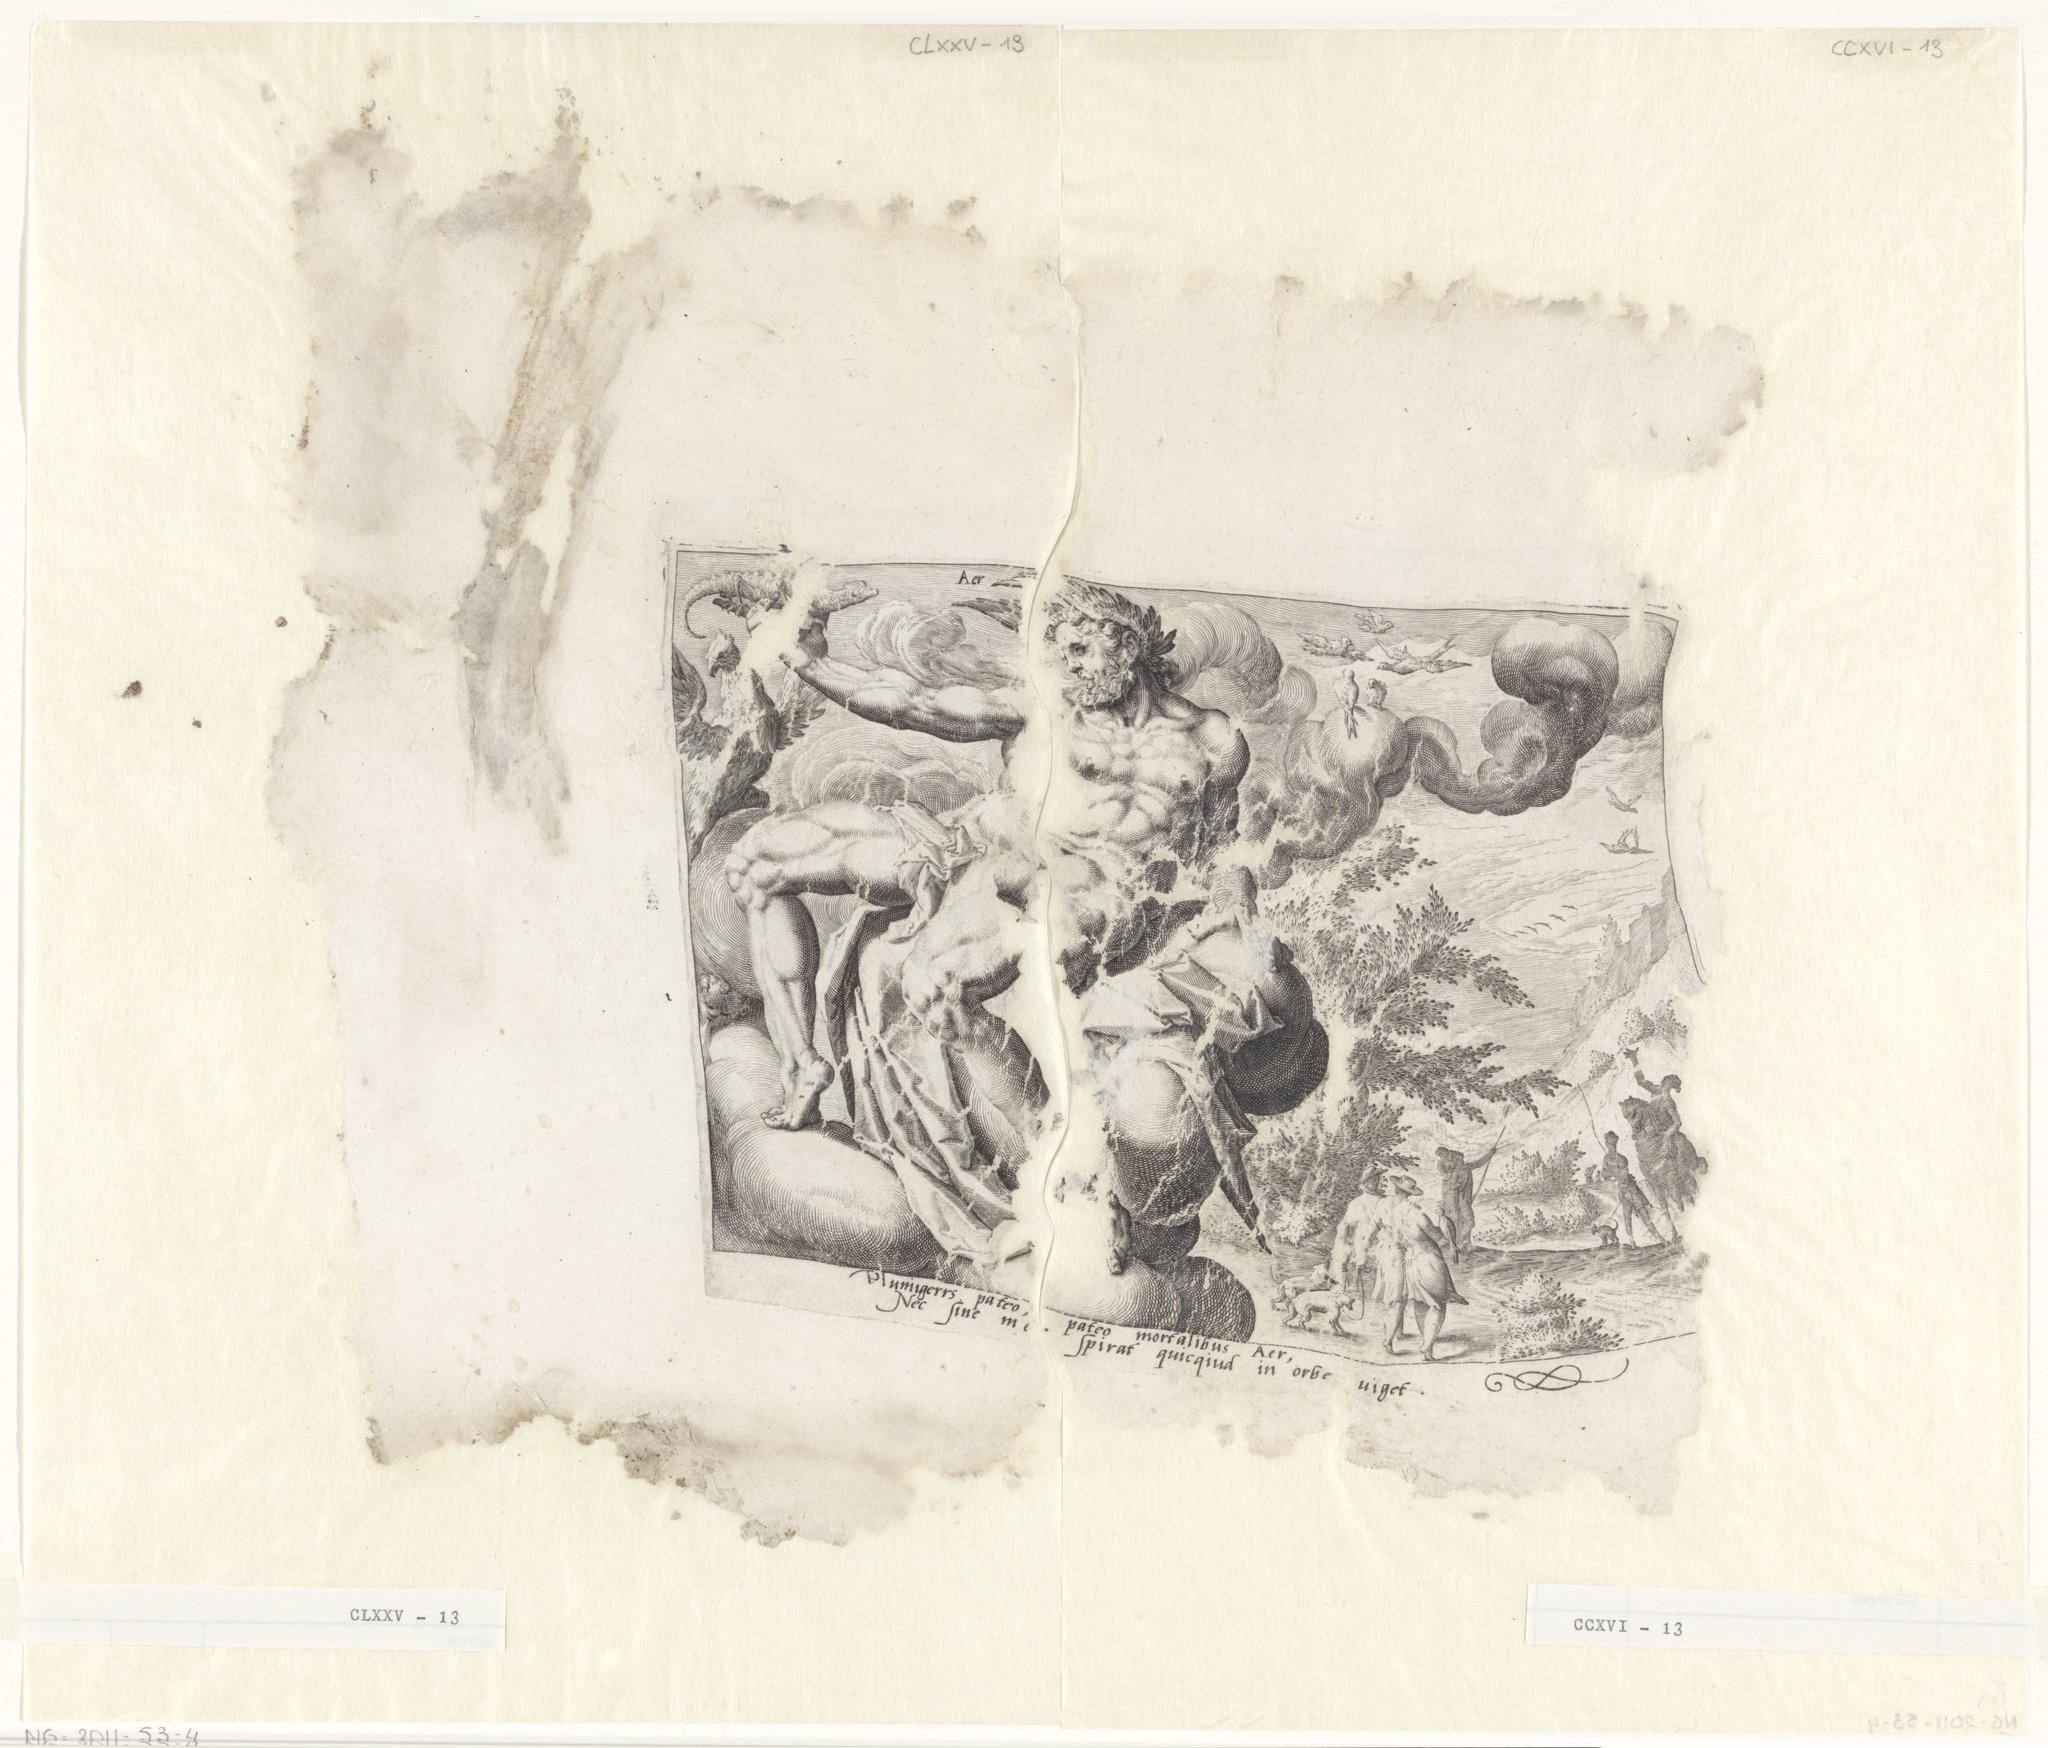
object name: print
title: Lucht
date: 1580-1596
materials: paper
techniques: engraving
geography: amsterdam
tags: air (one of the four elements)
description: De prenten in de Nova Zembla collectie zijn tijdens een expeditie van Willem Barendsz en Jacob van Heemskerk in 1596-1597 noodgedwongen in het winterkamp, het ‘Behouden Huis’, op het eiland achtergelaten. De prenten waren in één of meerdere stapels als handelswaar meegenomen vanuit Amsterdam. Bijna drie eeuwen later, in 1871, keerde de Noor Elling Carlsen terug naar Nova Zembla en vond daar de restanten van het ‘Behouden Huis, inclusief een groot deel van de inventaris. Een deel van de prenten, in de vorm van aaneengekoekte kluiten, werd toen ook teruggevonden. De papierkluiten waren soms op meerdere plekken gebroken. Tussen 1975-1979 zijn de prenten van elkaar gescheiden. Dit leverde in totaal ca. 1000 fragmenten van ca. 400 afdrukken van ca. 150 verschillende prenten op. Voor zover mogelijk zijn de fragmenten samengevoegd en zijn de prenten gereconstrueerd.